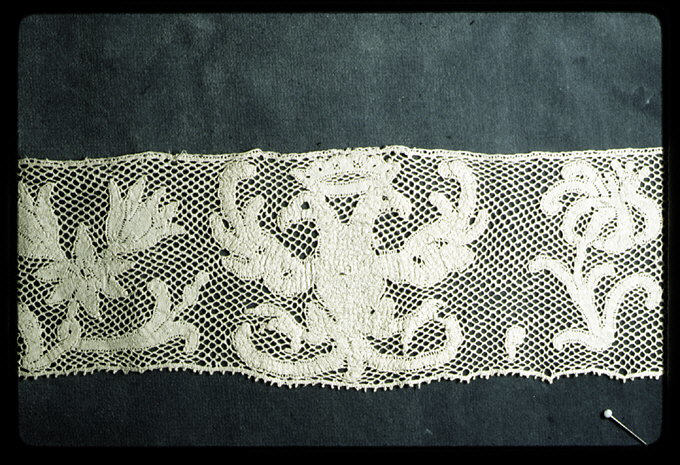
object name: border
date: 1701-1800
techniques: lace